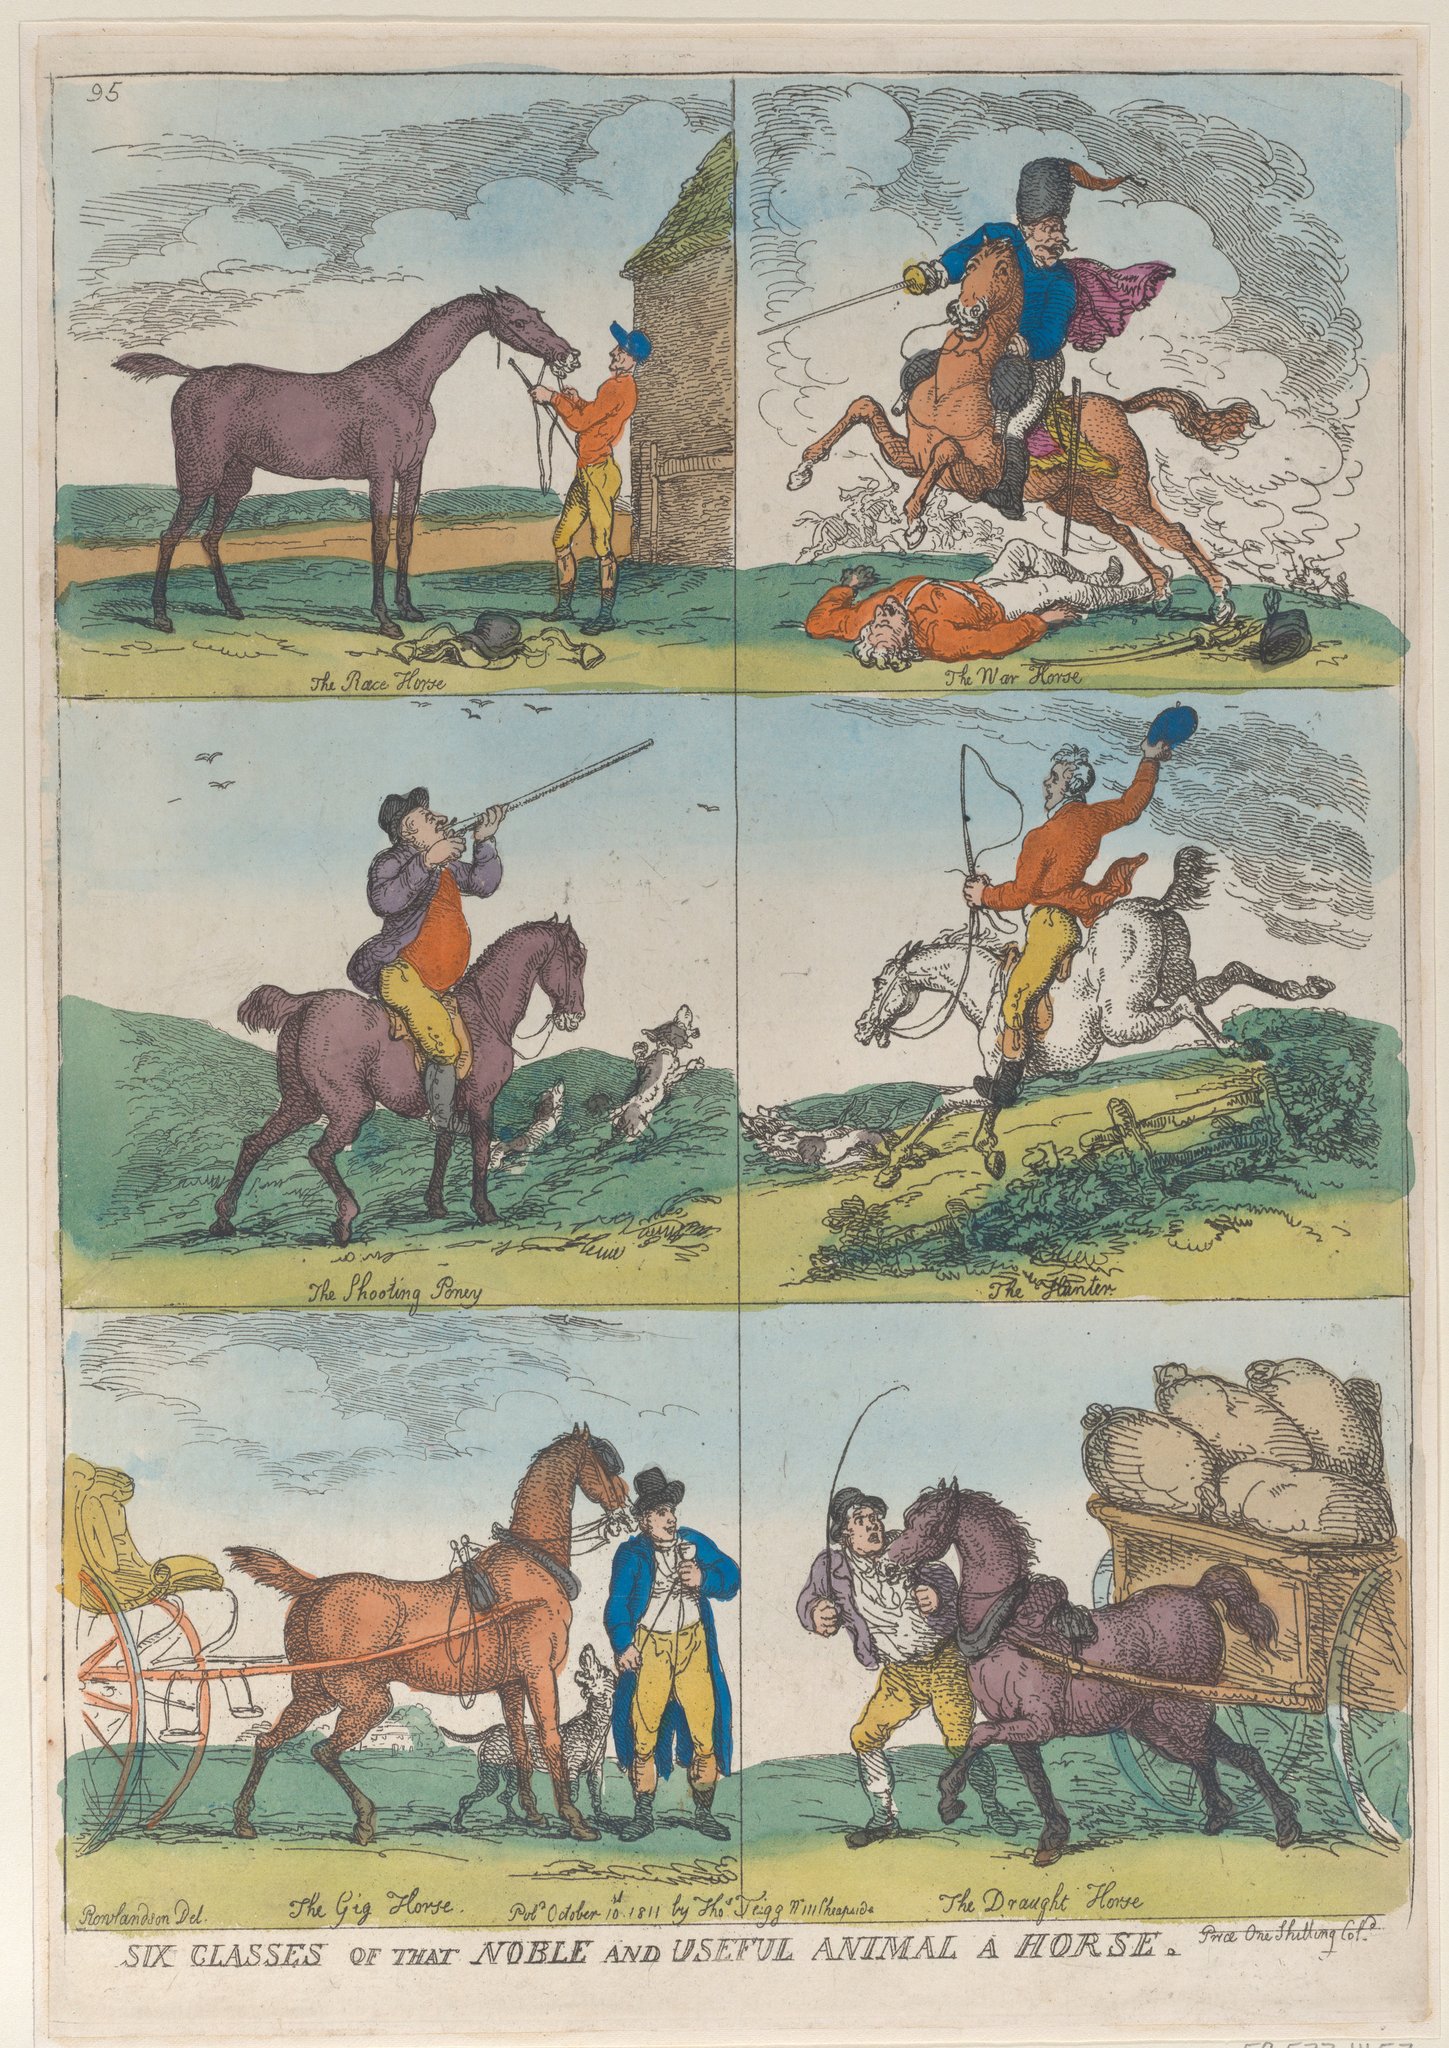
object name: print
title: Six Classes of the Noble and Useful Animal a Horse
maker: thomas rowlandson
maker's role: artist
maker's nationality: british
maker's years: 1757-1827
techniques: etching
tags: satire,men,hunting,horses